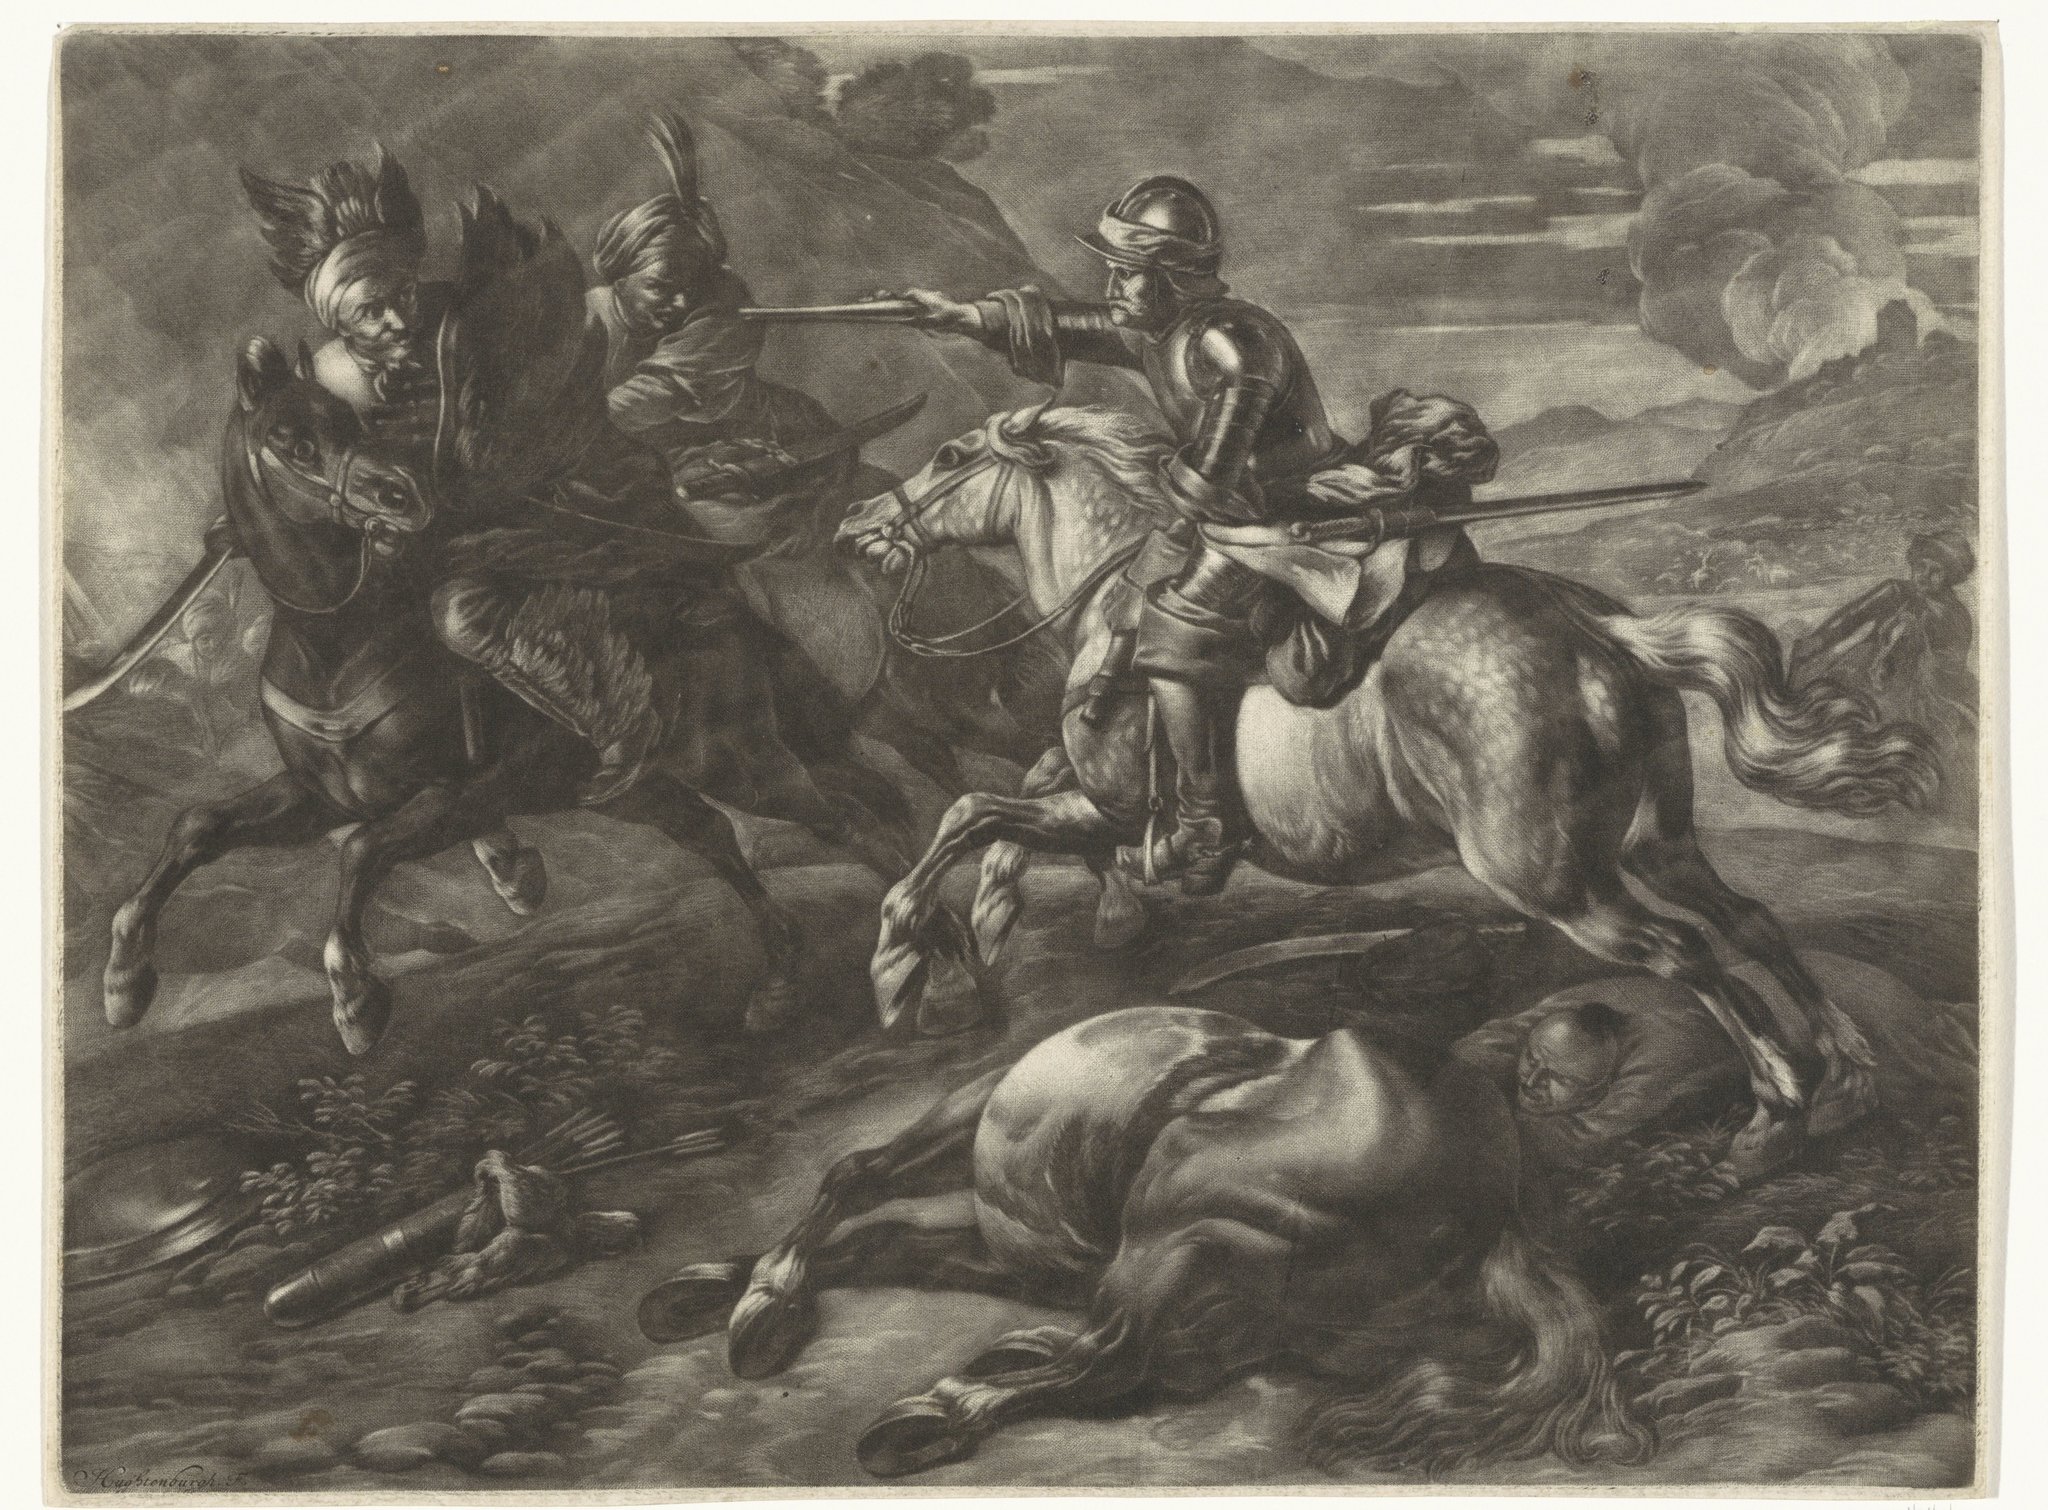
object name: print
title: Ruiters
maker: jan van huchtenburg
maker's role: draughtsman, painter, print maker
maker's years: 1647-1733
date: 1657-1733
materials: paper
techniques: engraving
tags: asiatic races and peoples: turks, battle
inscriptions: collector's mark: Lugt 2228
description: De Janitsaren zijn verwikkeld in een ruitergevecht met een andere partij. Op de achtergrond een brandende stad. Janitsaren waren de elitetroepen van het Ottomaanse hof. De prent maakt deel uit van een serie van vier met ruiters.